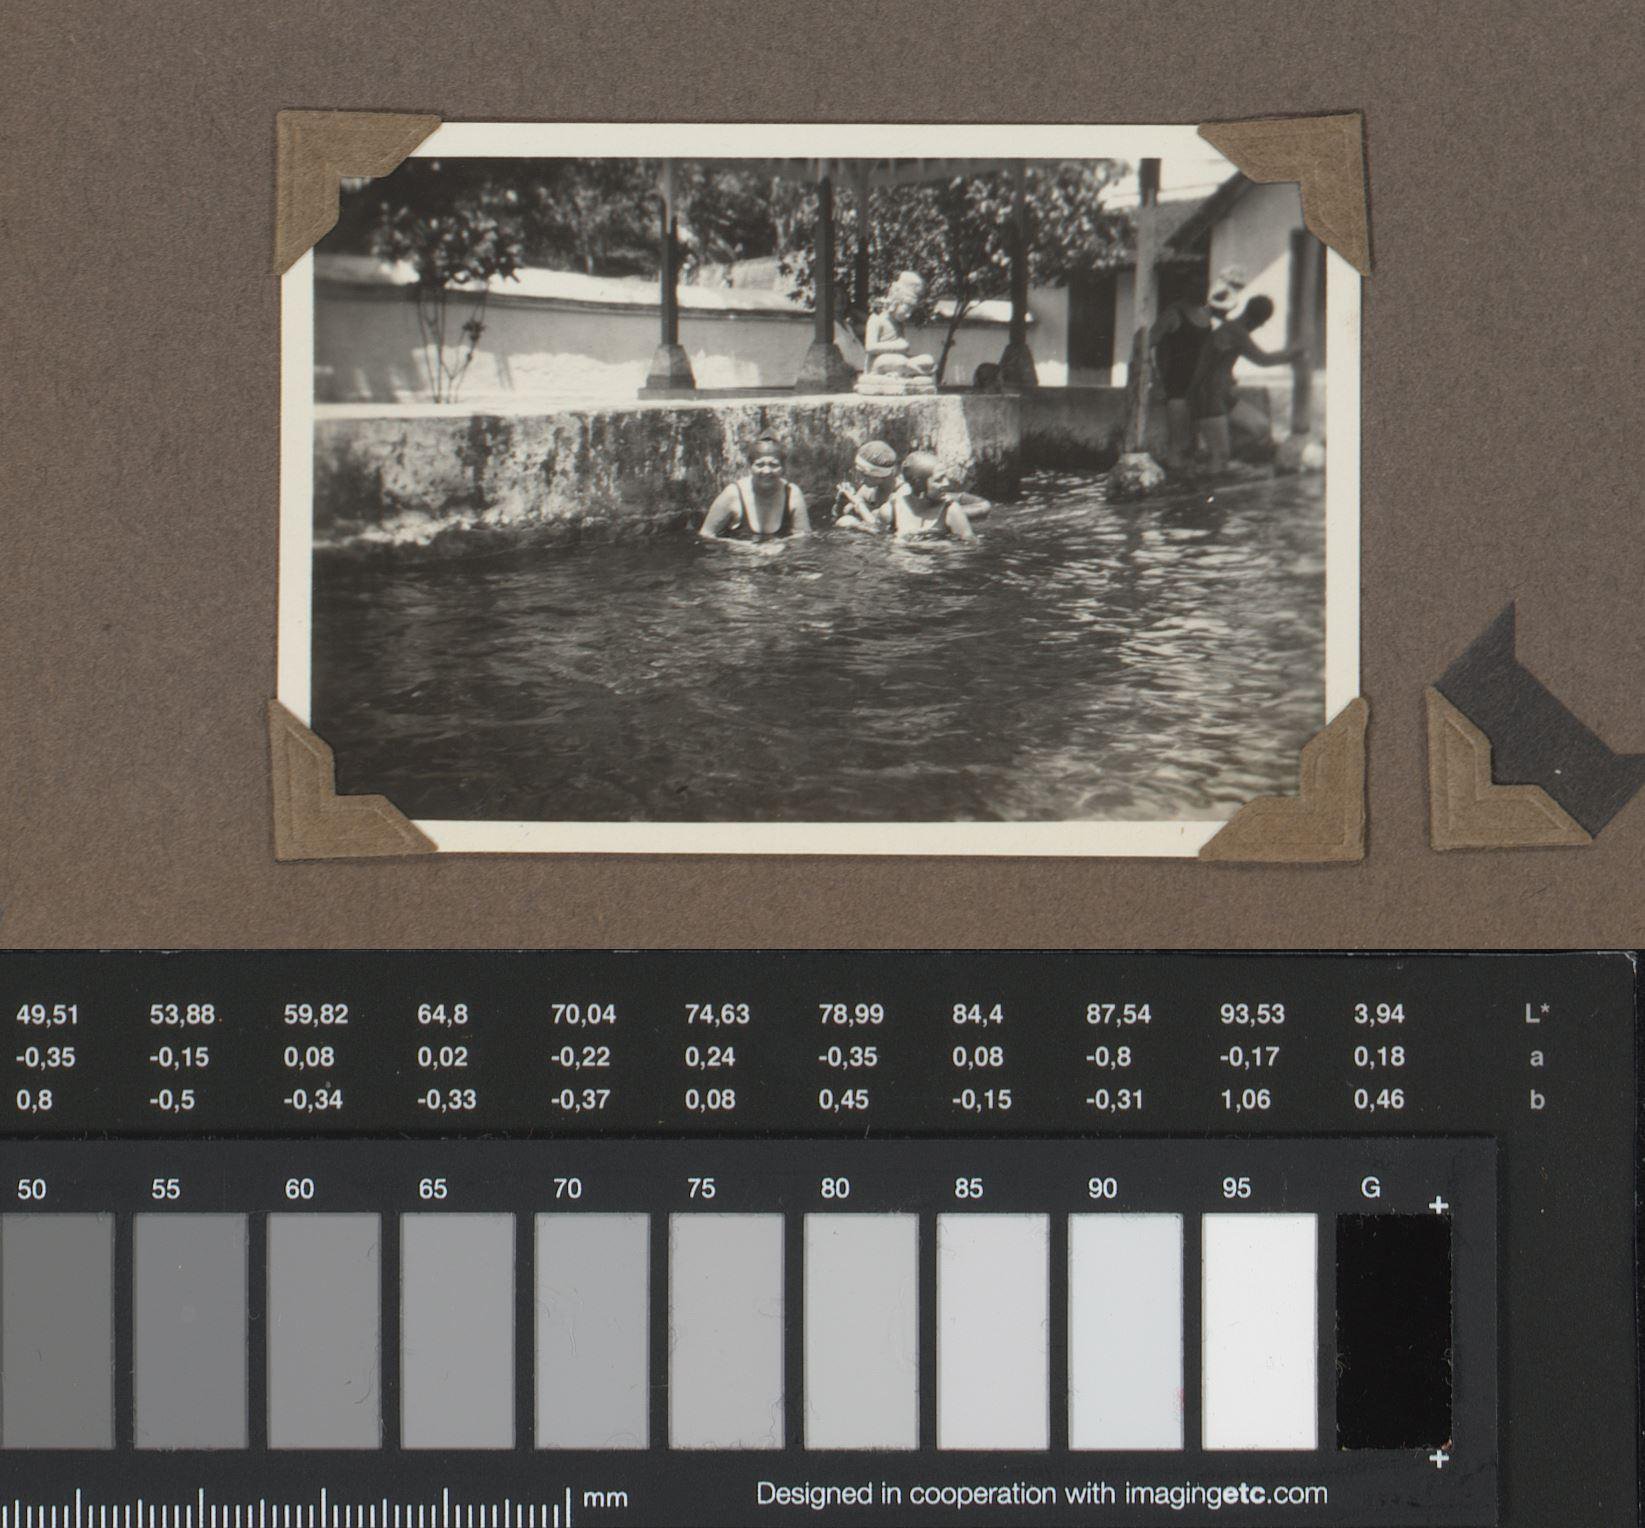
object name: photograph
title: Wilhelmina en Dootje van Zijll de Jong met een ander, zwemmend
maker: Anonymous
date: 1930-1935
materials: paper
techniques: gelatin silver print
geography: dutch east indies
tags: amsterdam, the hague, wilhelmina van zijll de jong, swimming (movement in water), dutch east indies, the